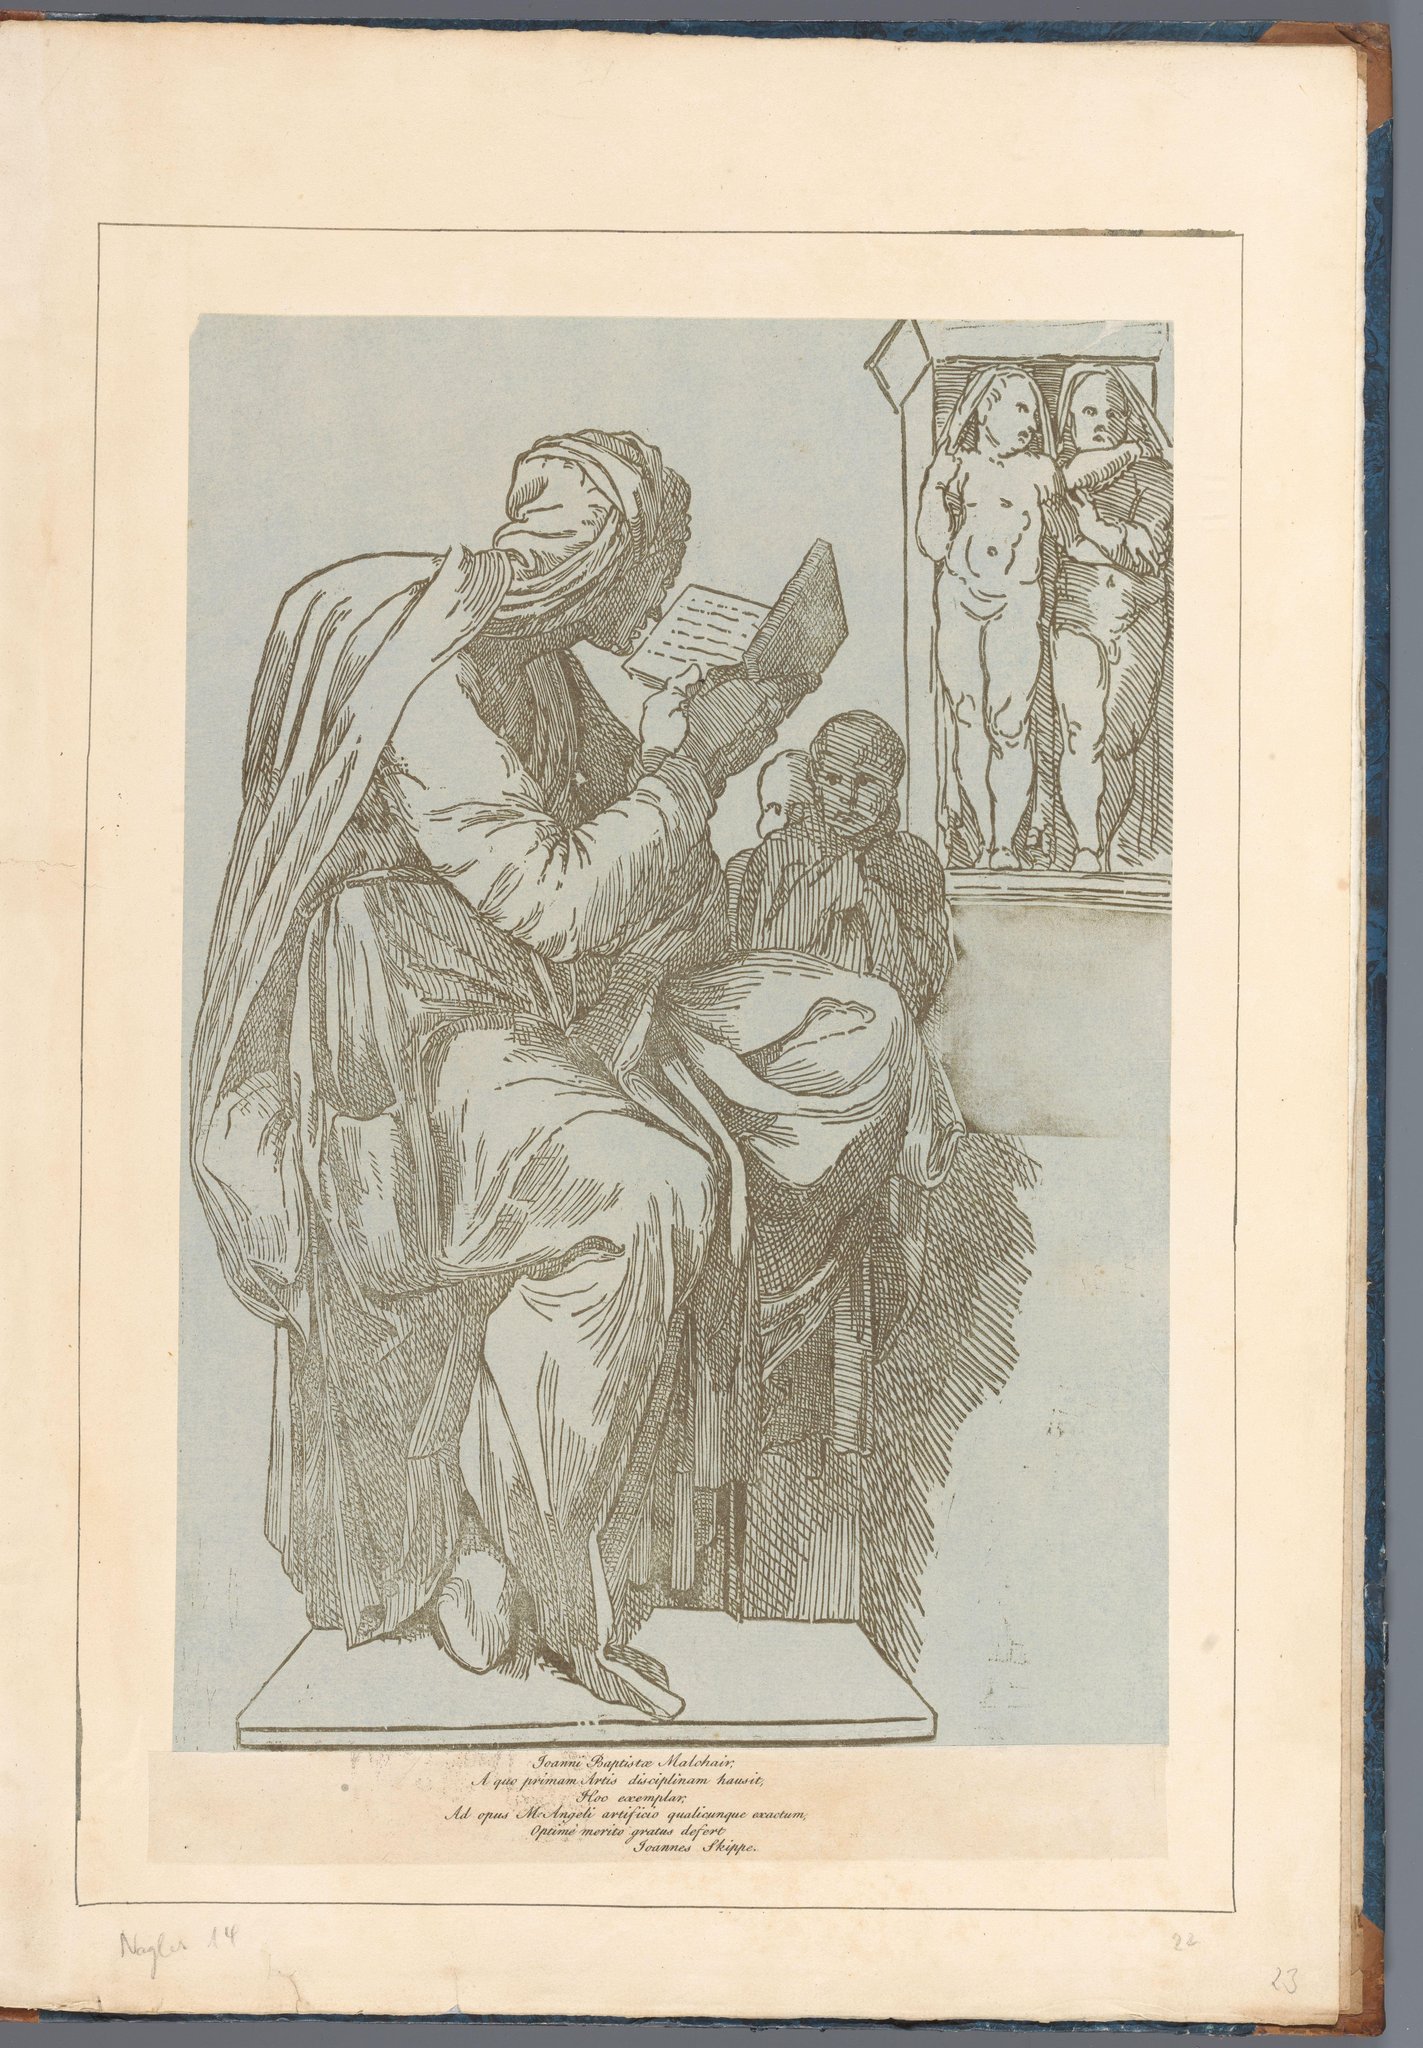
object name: print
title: Amicis suis necnon unicuique (...)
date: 1782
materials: ink, paper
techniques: woodcut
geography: england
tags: persian sibyl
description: De Perzische Sibille, geschilderd tussen de ramen in de Sixtijnse kapel. In deze staat zijn de opschriften rechts in de voorstelling verwijderd. Met etiket met zesregelige tekst in het Latijn waarin vermeld de naam: John Baptist Malchair. Onderdeel van een album met 26 ingeplakte clair-obscur houtsneden naar Italiaanse kunstenaars uit de zestiende eeuw.